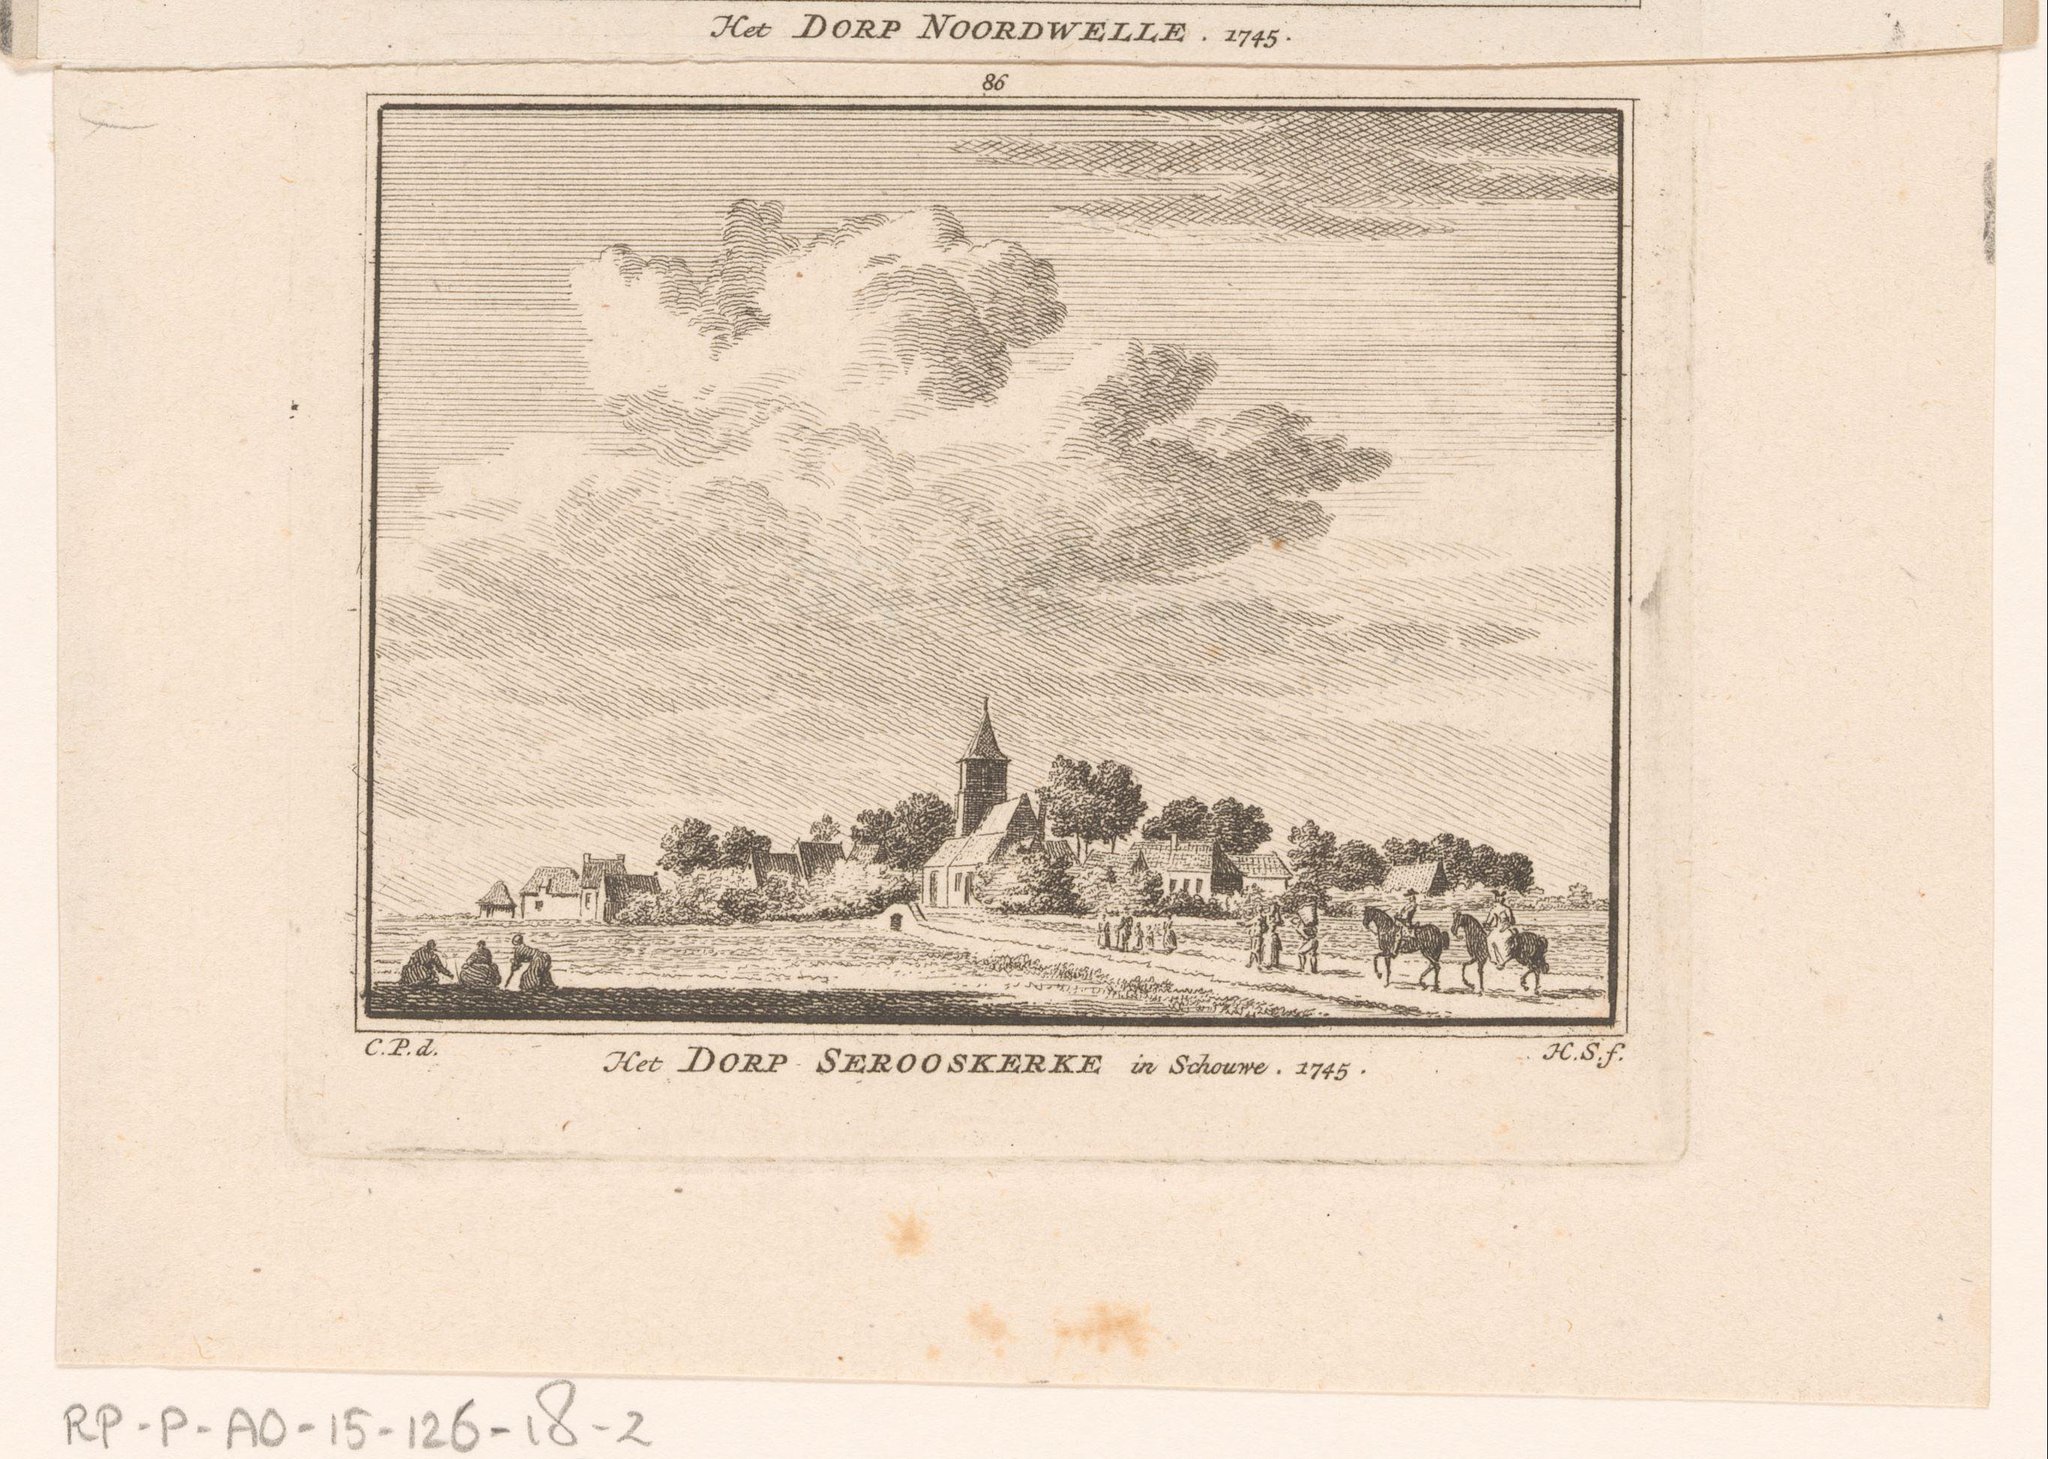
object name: print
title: Gezicht op Noordwelle, 1745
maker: hendrik spilman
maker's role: draughtsman, painter, print maker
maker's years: 1721-1784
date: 1754-1792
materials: paper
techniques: etching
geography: haarlem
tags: prospect of village, silhouette of village, church (exterior)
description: Prent ook gebruikt in: Het verheerlykt Nederland of kabinet van hedendaagsche gezigten van steden, dorpen (…). 9 delen. Amsterdam: Isaak Tirion en weduwe Isaak Tirion, 1745-1774, dl. 5 (1754), ill. 85. Of in: Nederlandsche tafereelen; of eene keurige verzameling van negen honderd fraaije gezigten van steden, dorpen, sloten, oudheden [….]. 9 delen. Amsterdam: Jan de Groot, 1792, dl. 5, ill. 85.